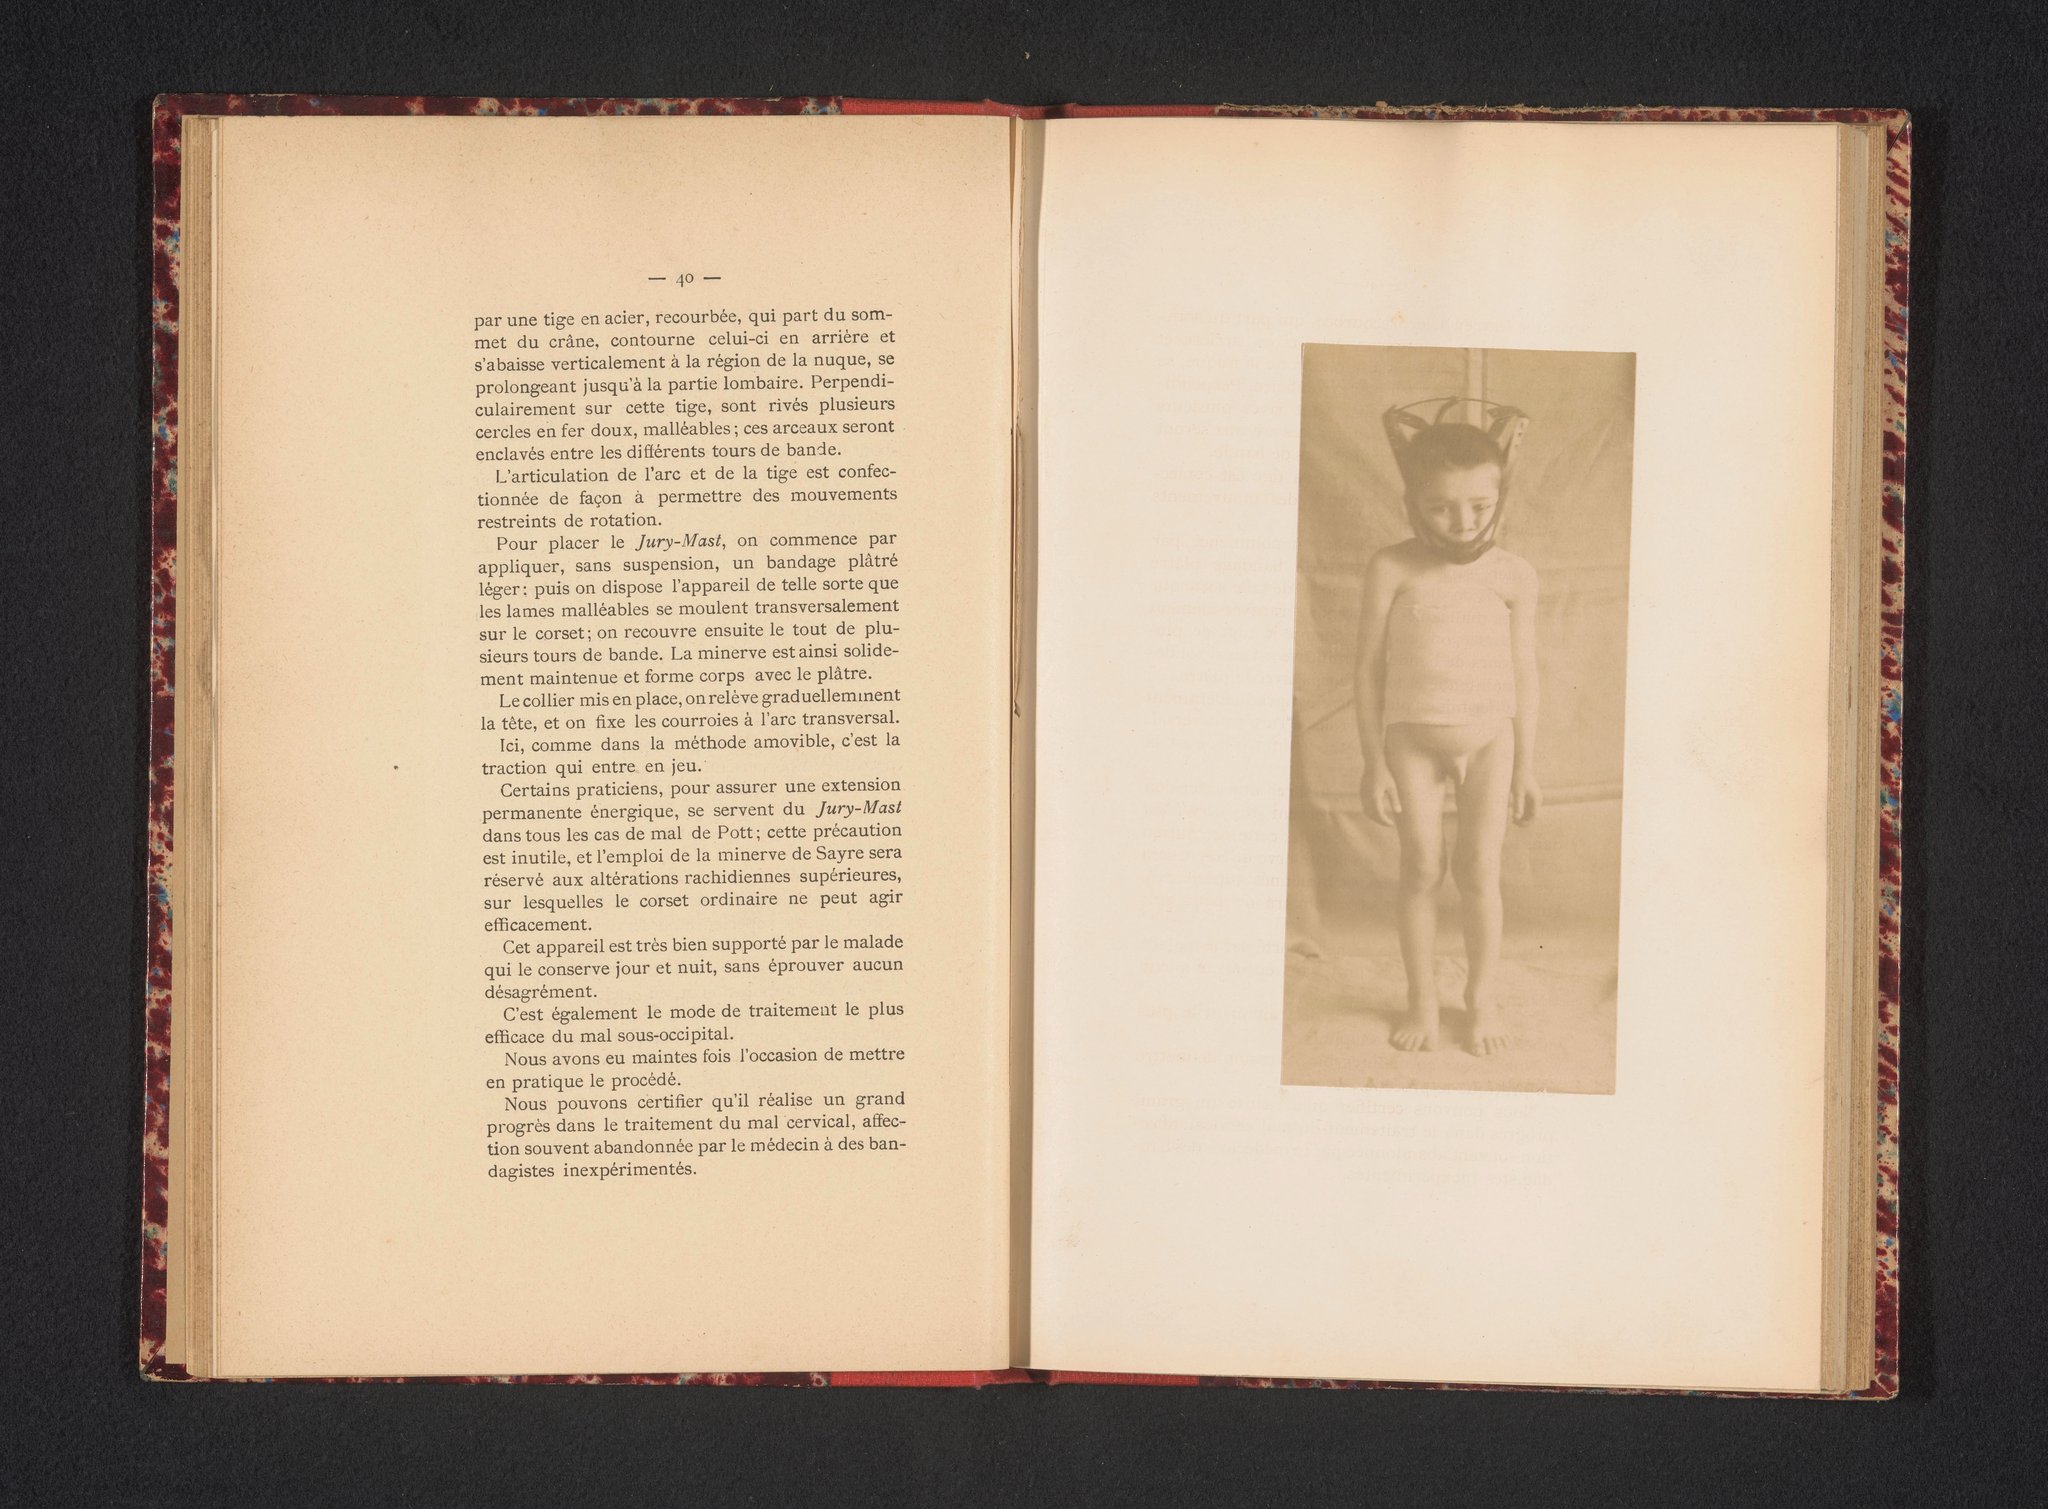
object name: photograph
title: Jongen ondergaat een behandeling voor problemen met zijn ruggengraat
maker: Anonymous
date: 1884-1889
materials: photographic support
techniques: albumen print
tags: boy (child between toddler and youth), medical examination, medical treatment